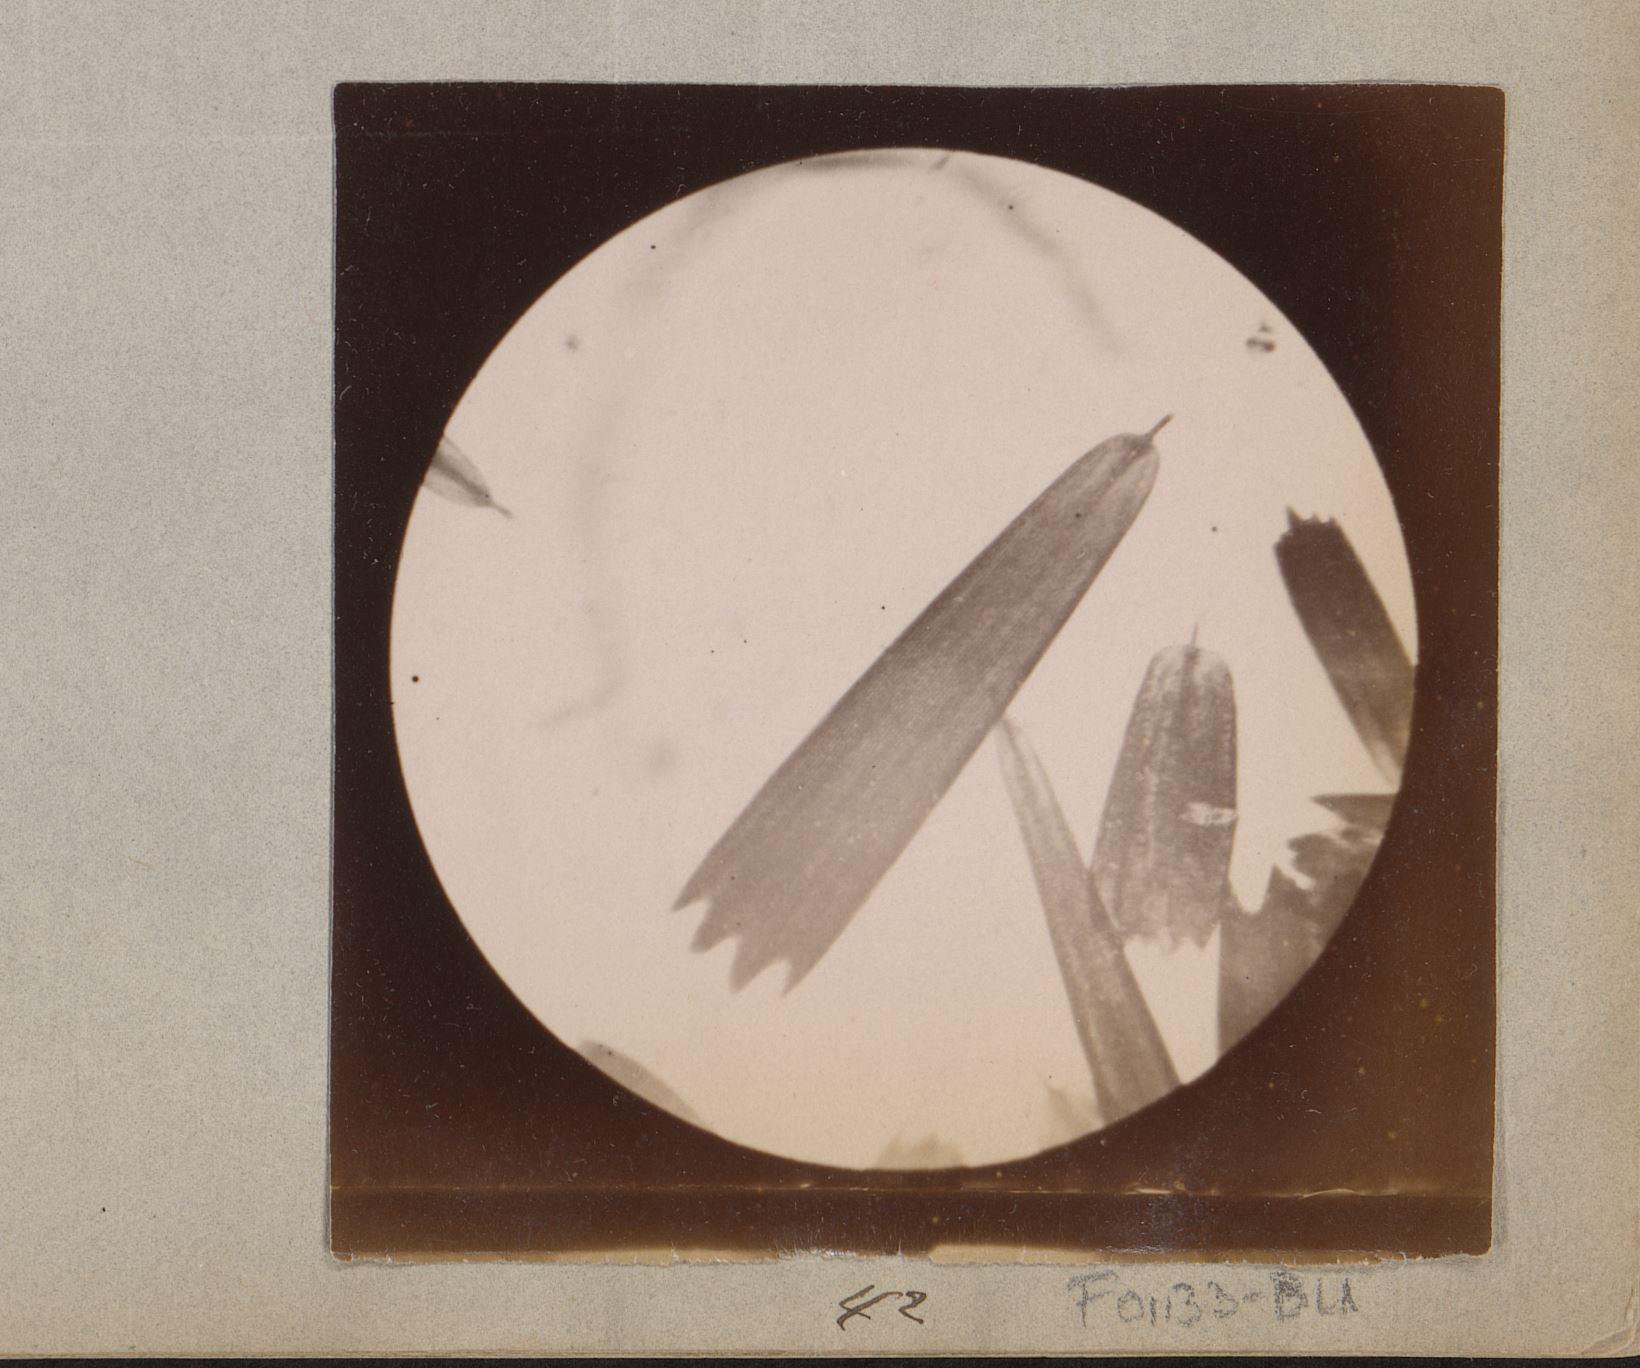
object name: photograph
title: Microscopische opname van een schub van een vlindervleugel, 350 keer vergroot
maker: marinus pieter filbri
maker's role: instrument maker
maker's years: 1852-1917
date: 1887-1888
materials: paper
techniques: albumen print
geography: netherlands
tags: insects: butterfly, netherlands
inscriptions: number: ‘42’, inscription: ‘No. 42. Benaming Schubje van een Kapel vleugel, 350 x vergroot, pose (?), Bemerking Lomb.’